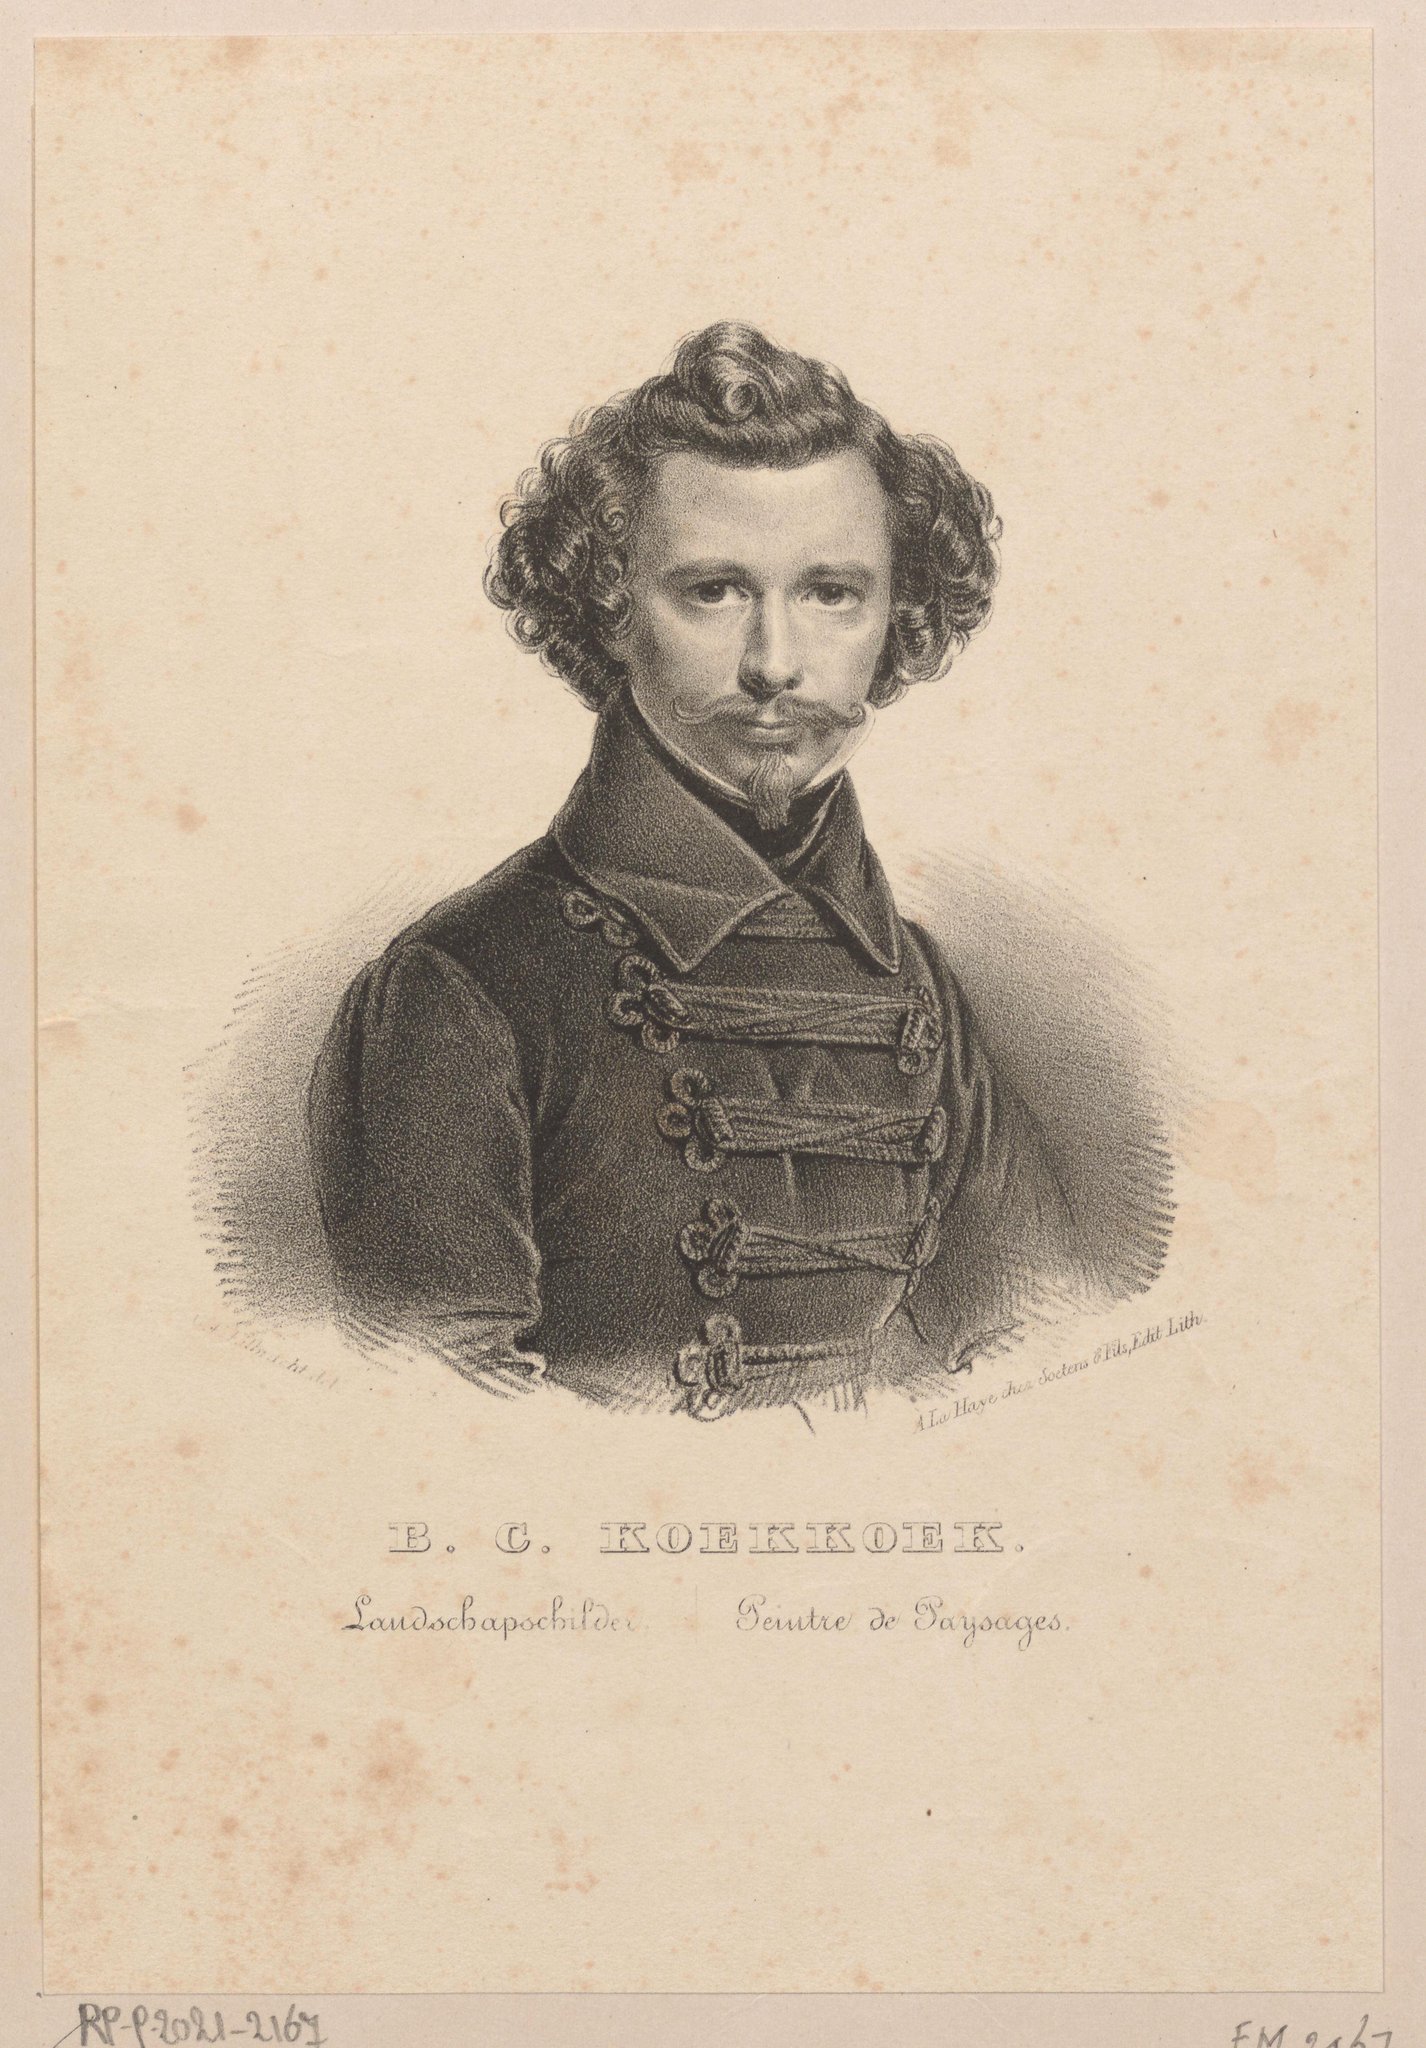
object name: print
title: Portret van Barend Cornelis Koekkoek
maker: gerhardus fredericus eilbracht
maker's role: draughtsman, print maker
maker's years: 1816-1854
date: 1837-1840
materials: paper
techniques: lithograph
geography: the hague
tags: middelburg, cleves, painter, barend cornelis koekkoek, historical persons, palette